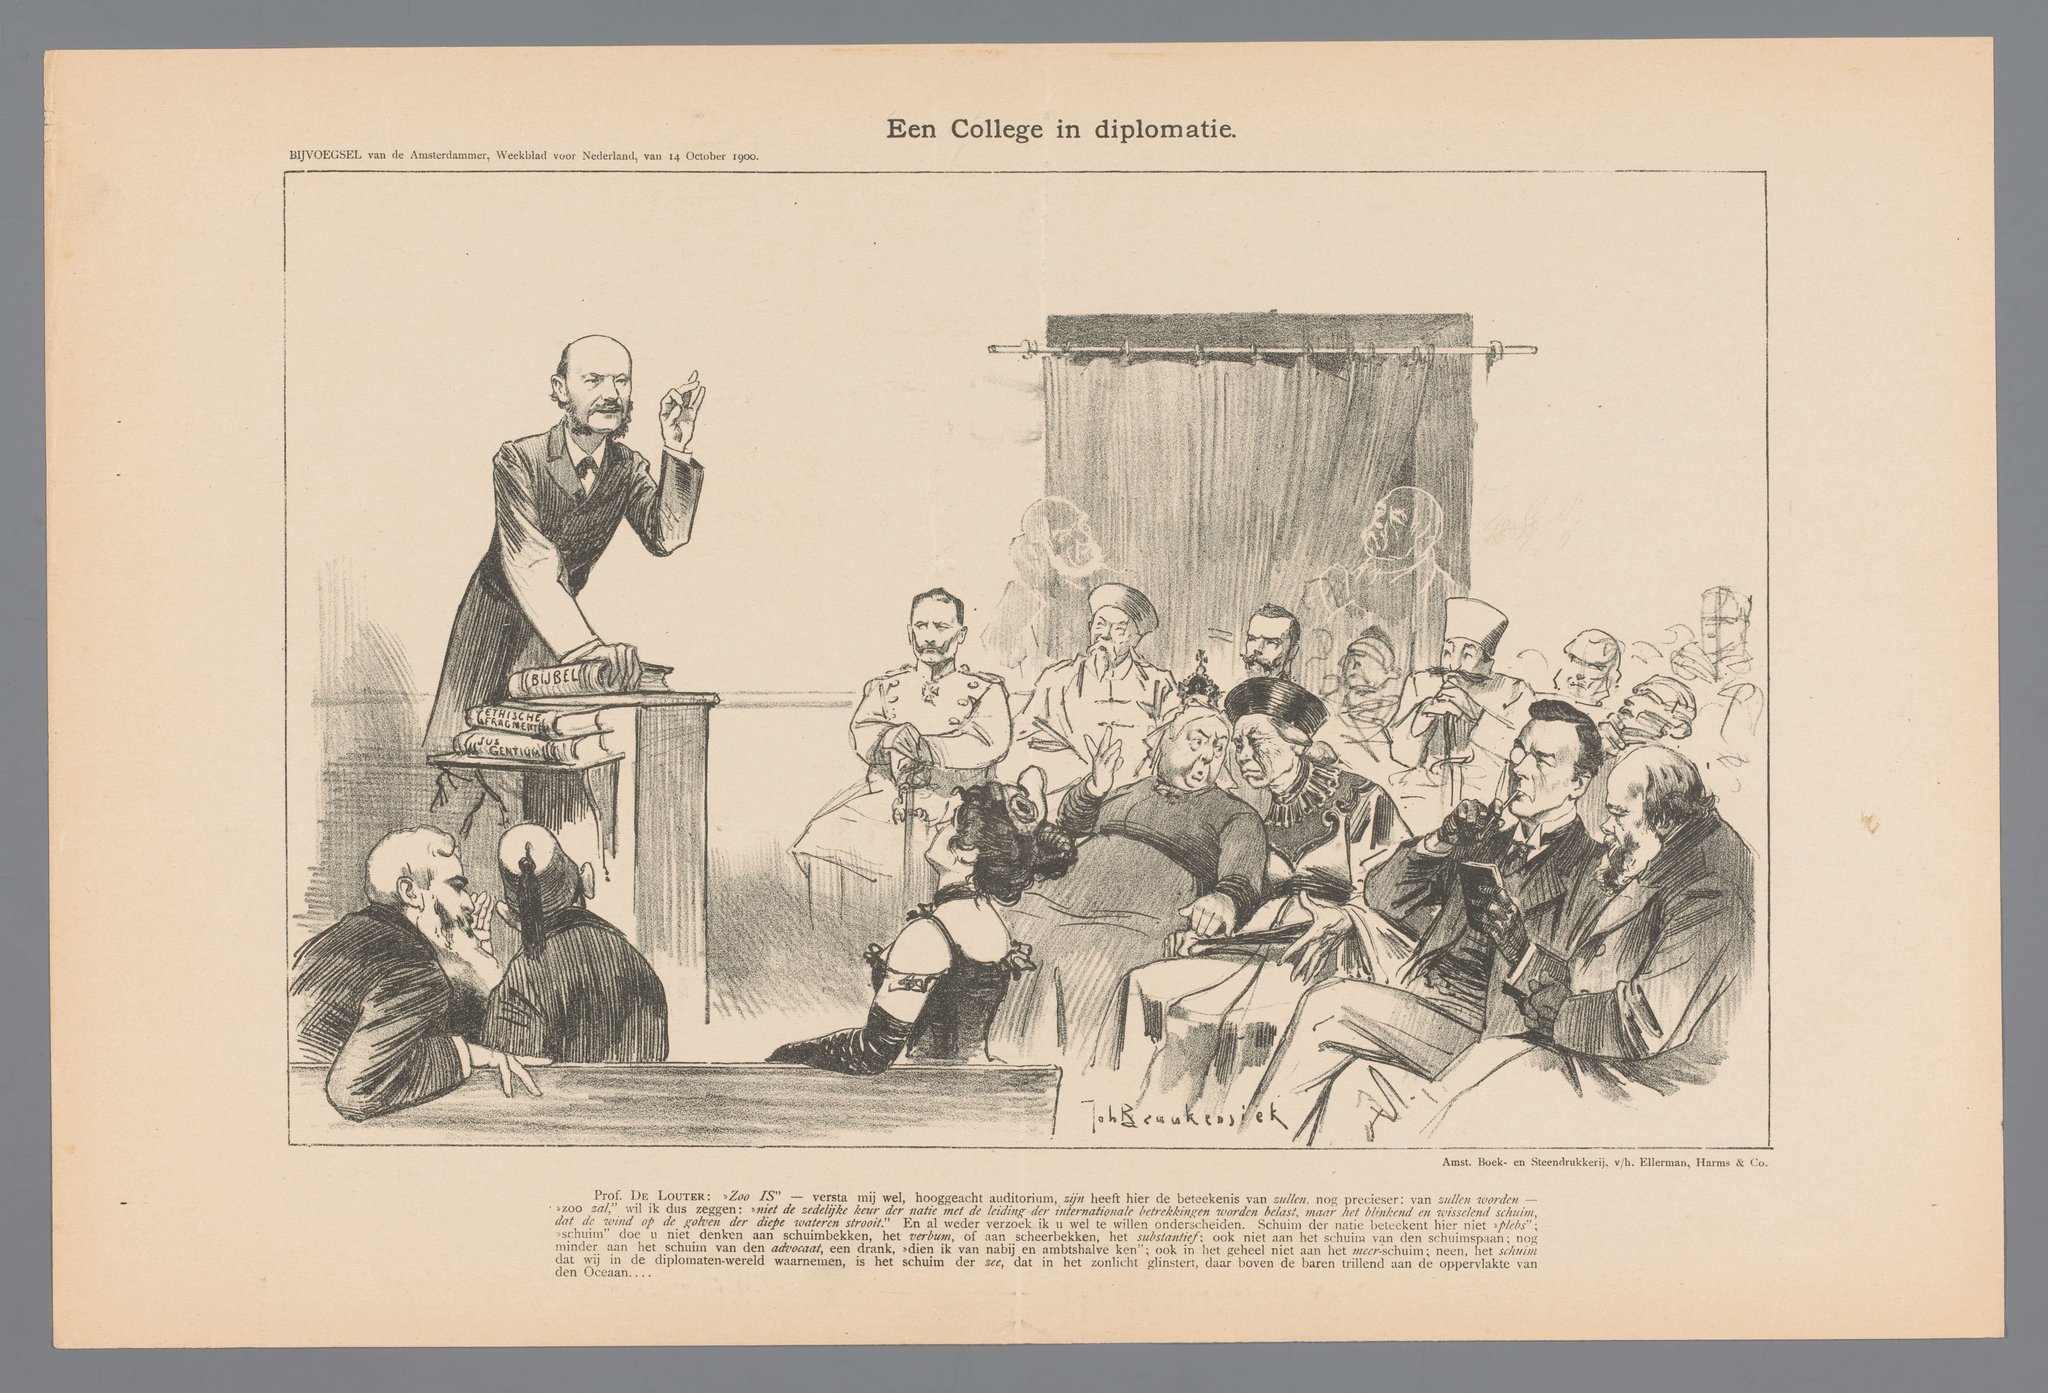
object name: cartoon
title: Een College in diplomatie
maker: johan braakensiek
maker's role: draughtsman, print maker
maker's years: 1858-1940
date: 1900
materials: paper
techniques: lithograph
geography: amsterdam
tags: victoria (koningin van het verenigd koninkrijk en keizerin van india), politician, historical persons, diplomacy, diplomat, ruler, sovereign, political caricatures and satires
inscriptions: date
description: Prent uit het bijvoegsel van: De Amsterdammer. Weekblad voor Nederland, 14 oktober 1900.